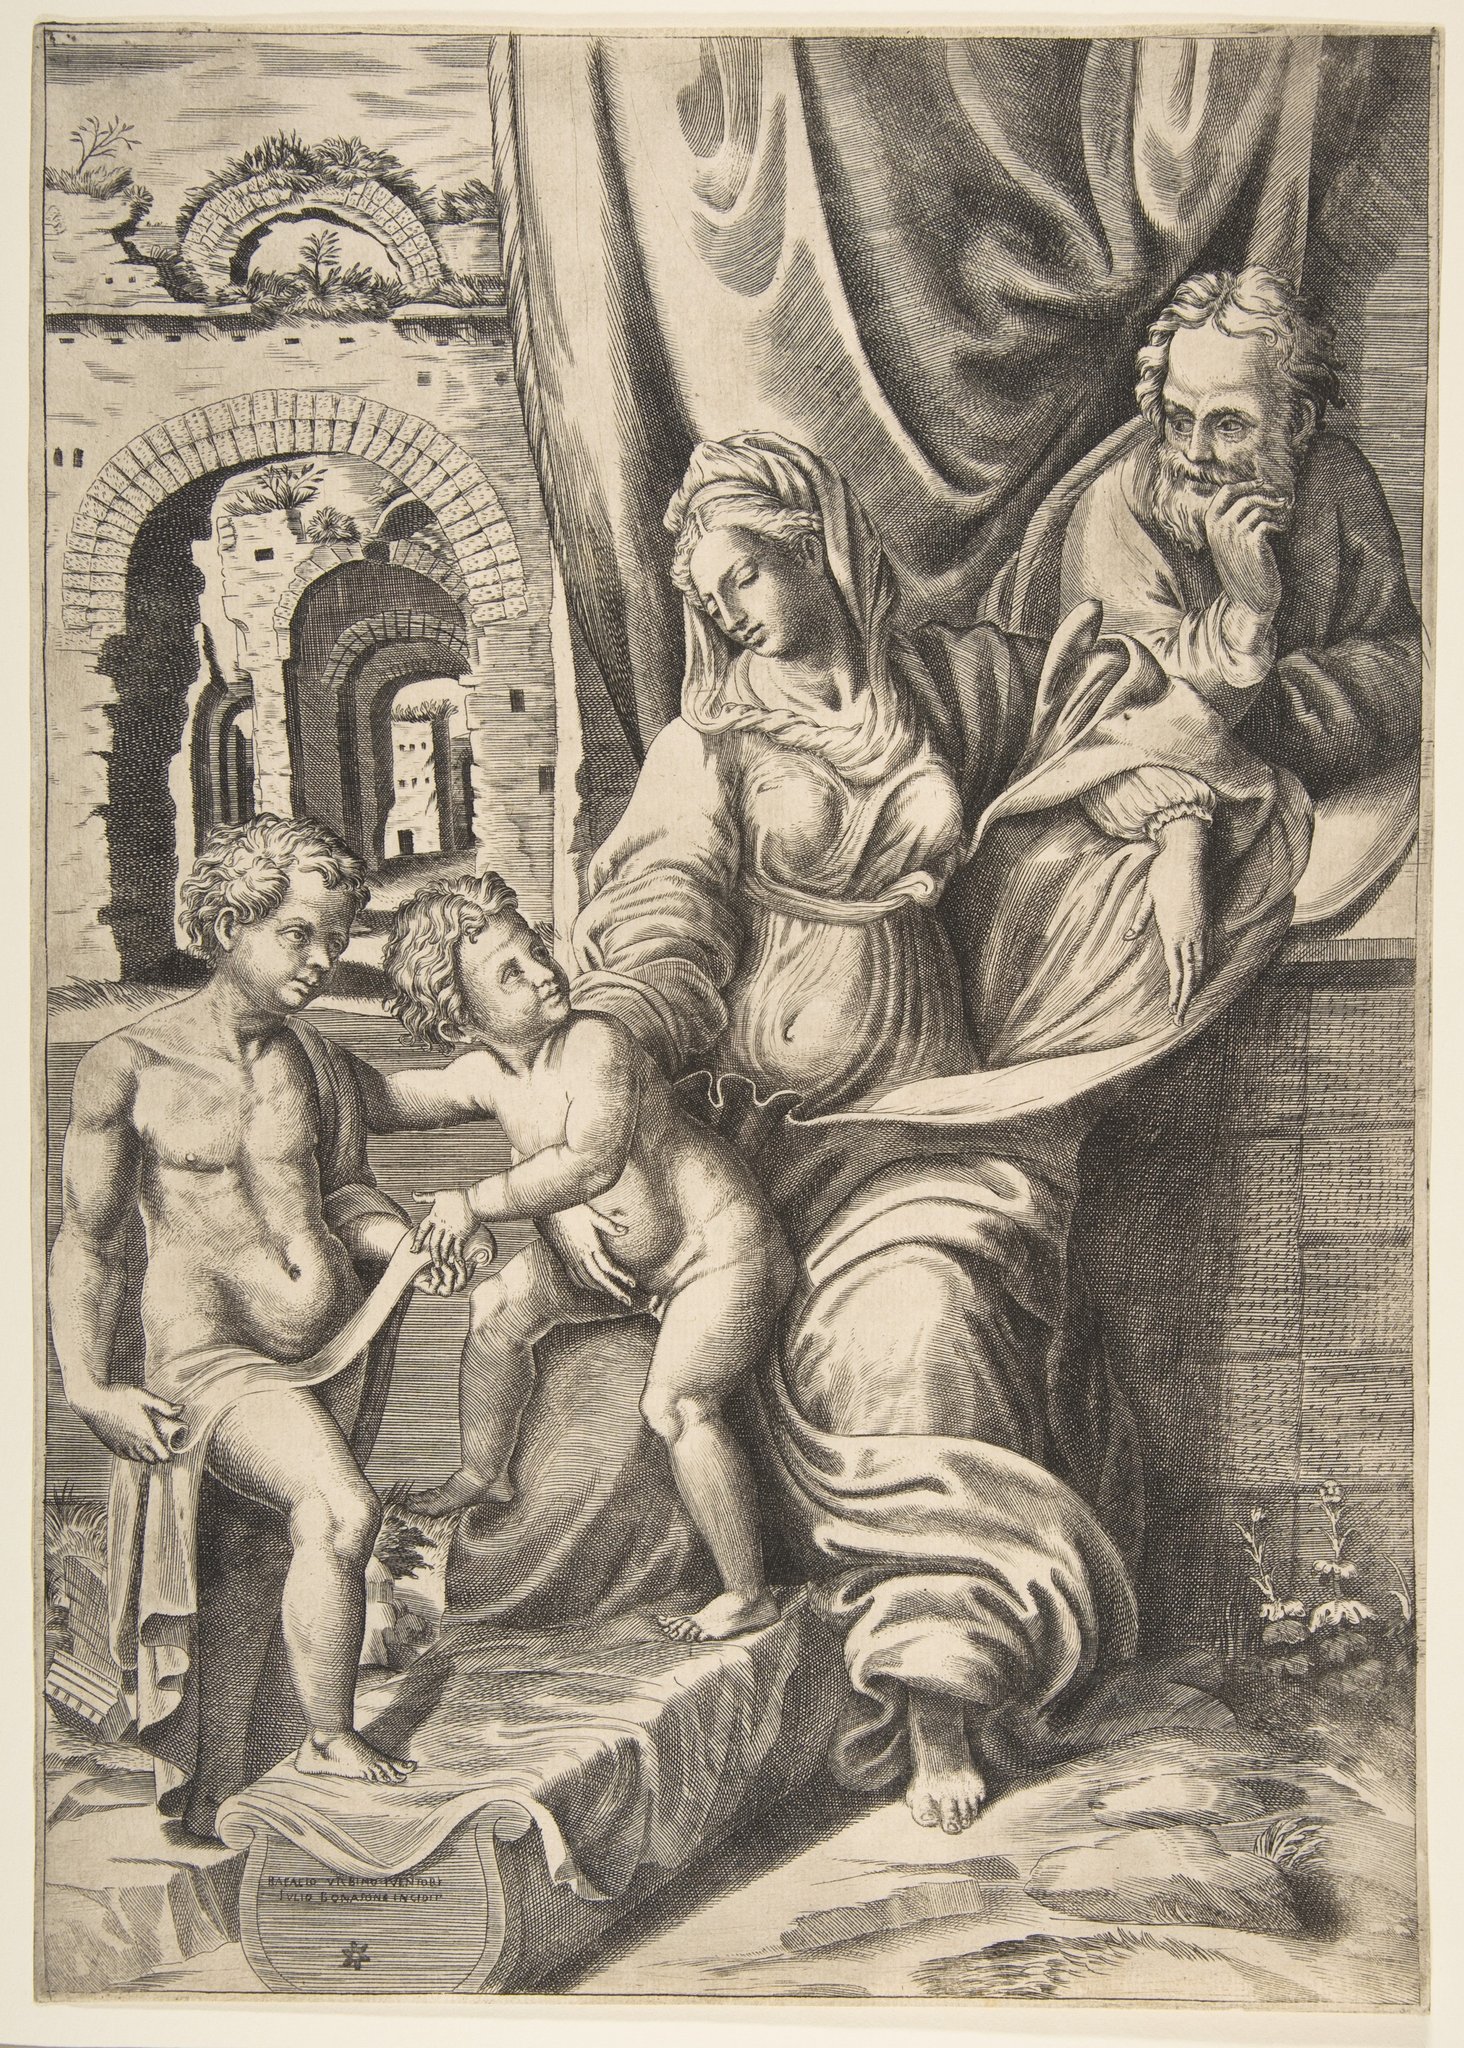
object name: print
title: The Holy Family and the infant John the Baptist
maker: giulio bonasone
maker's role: artist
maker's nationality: italian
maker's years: 1510-1576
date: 1531-1576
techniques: engraving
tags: holy family,saint john the baptist